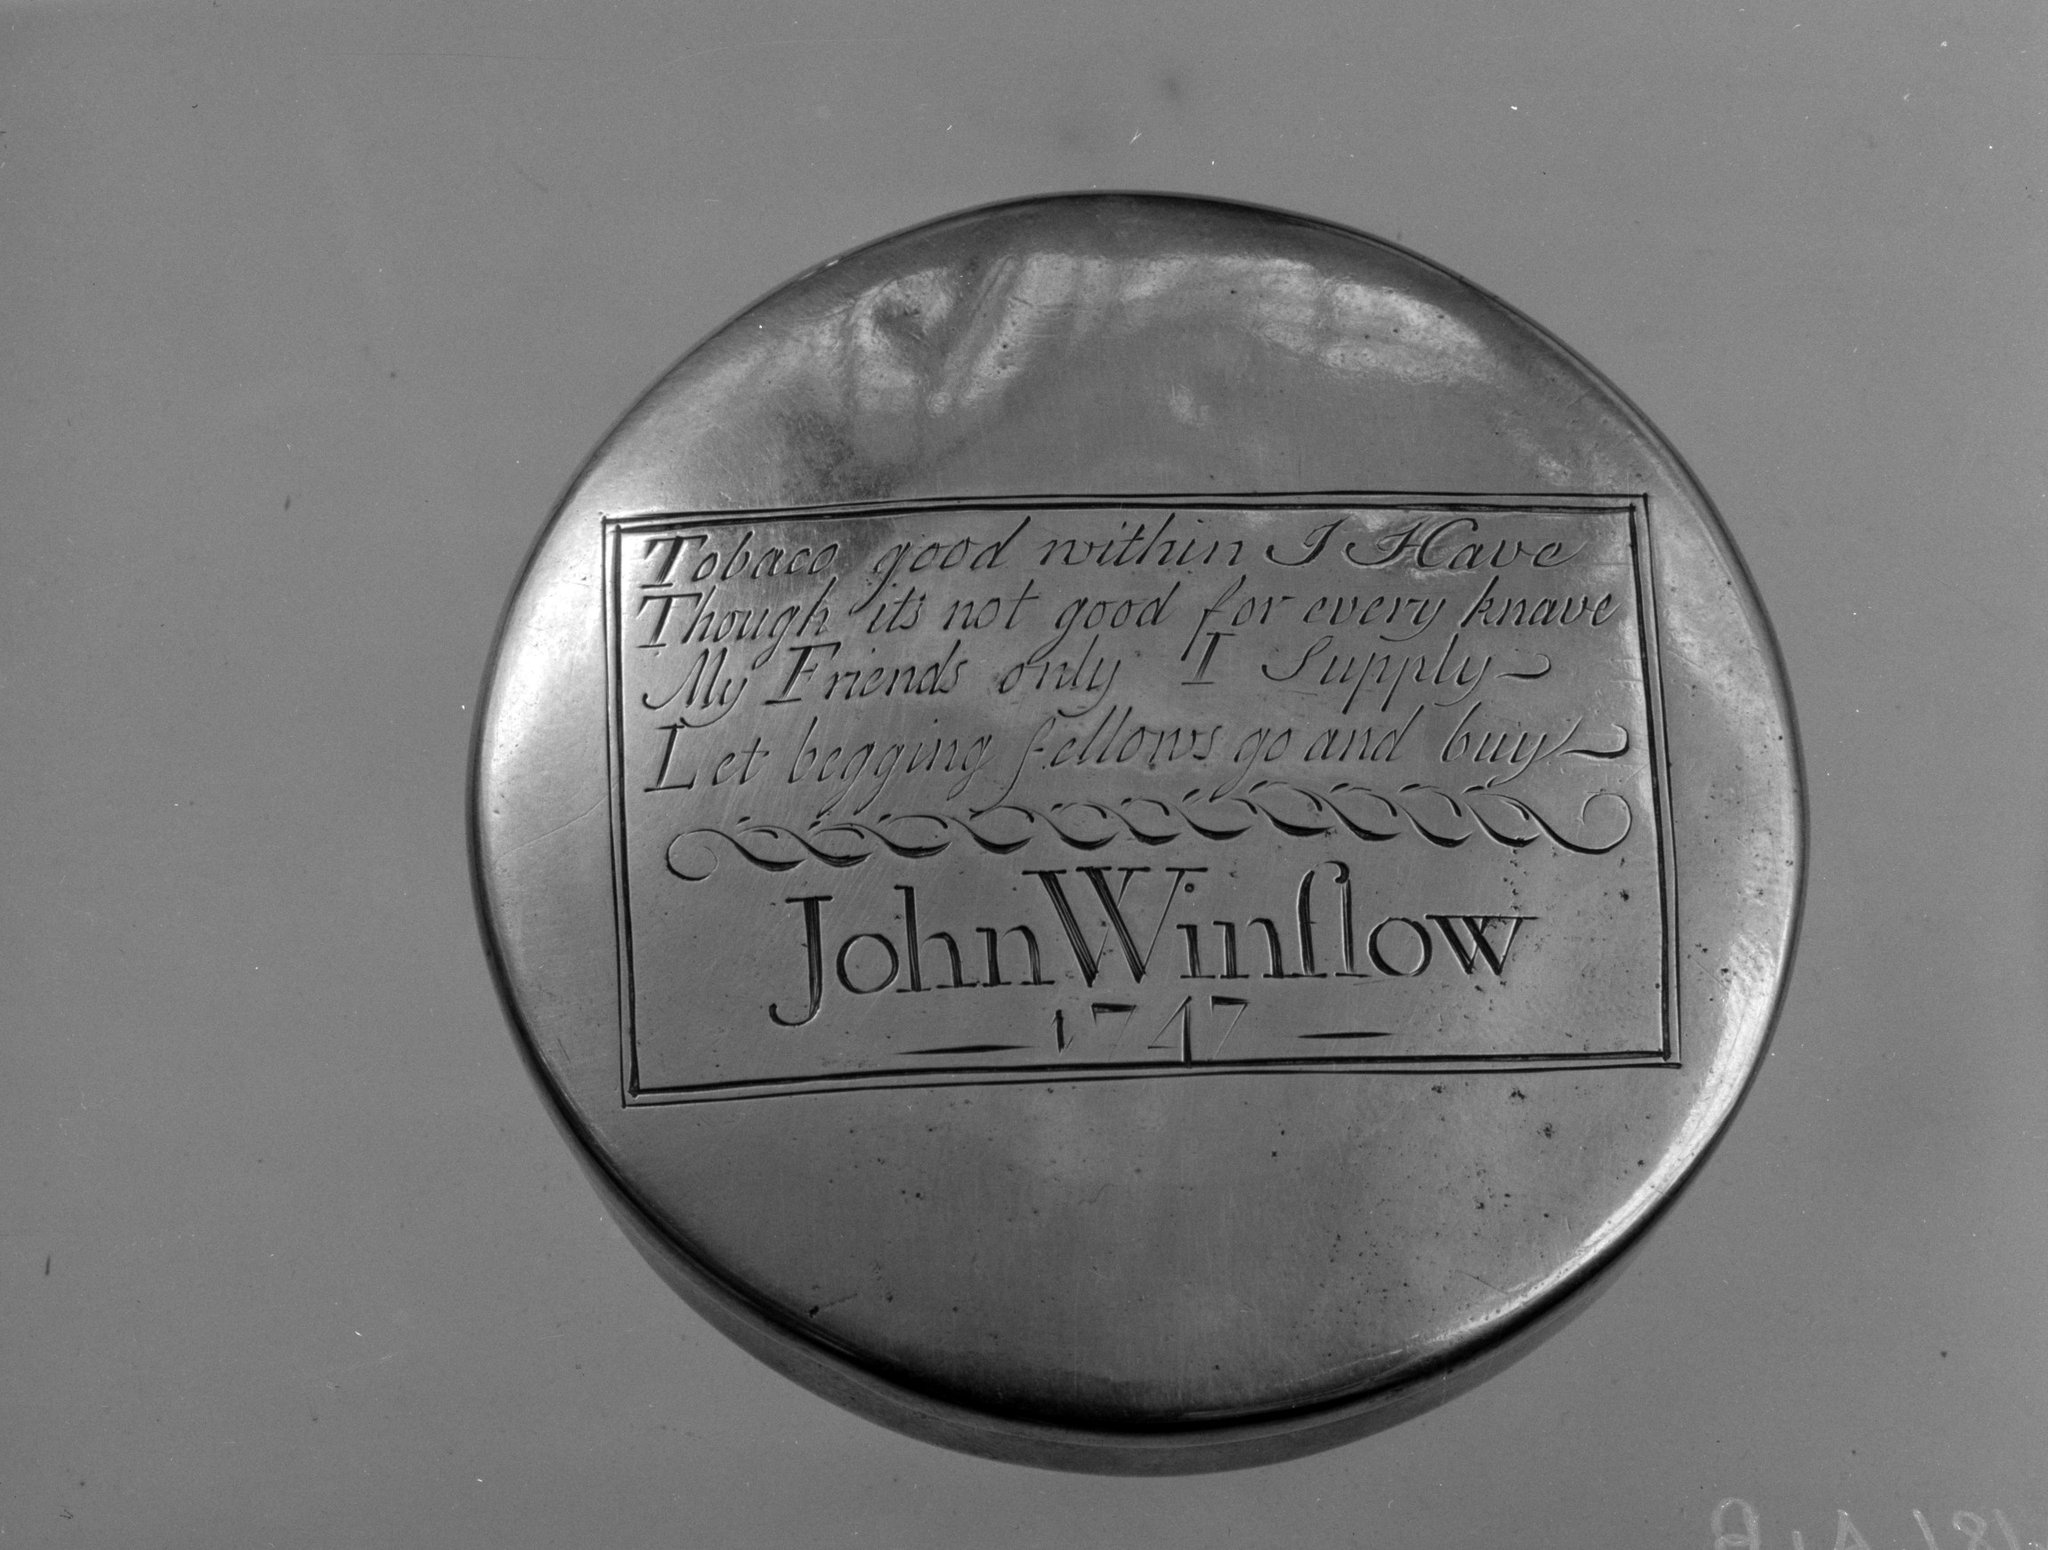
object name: tobacco box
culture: american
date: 1747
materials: brass, tin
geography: united states